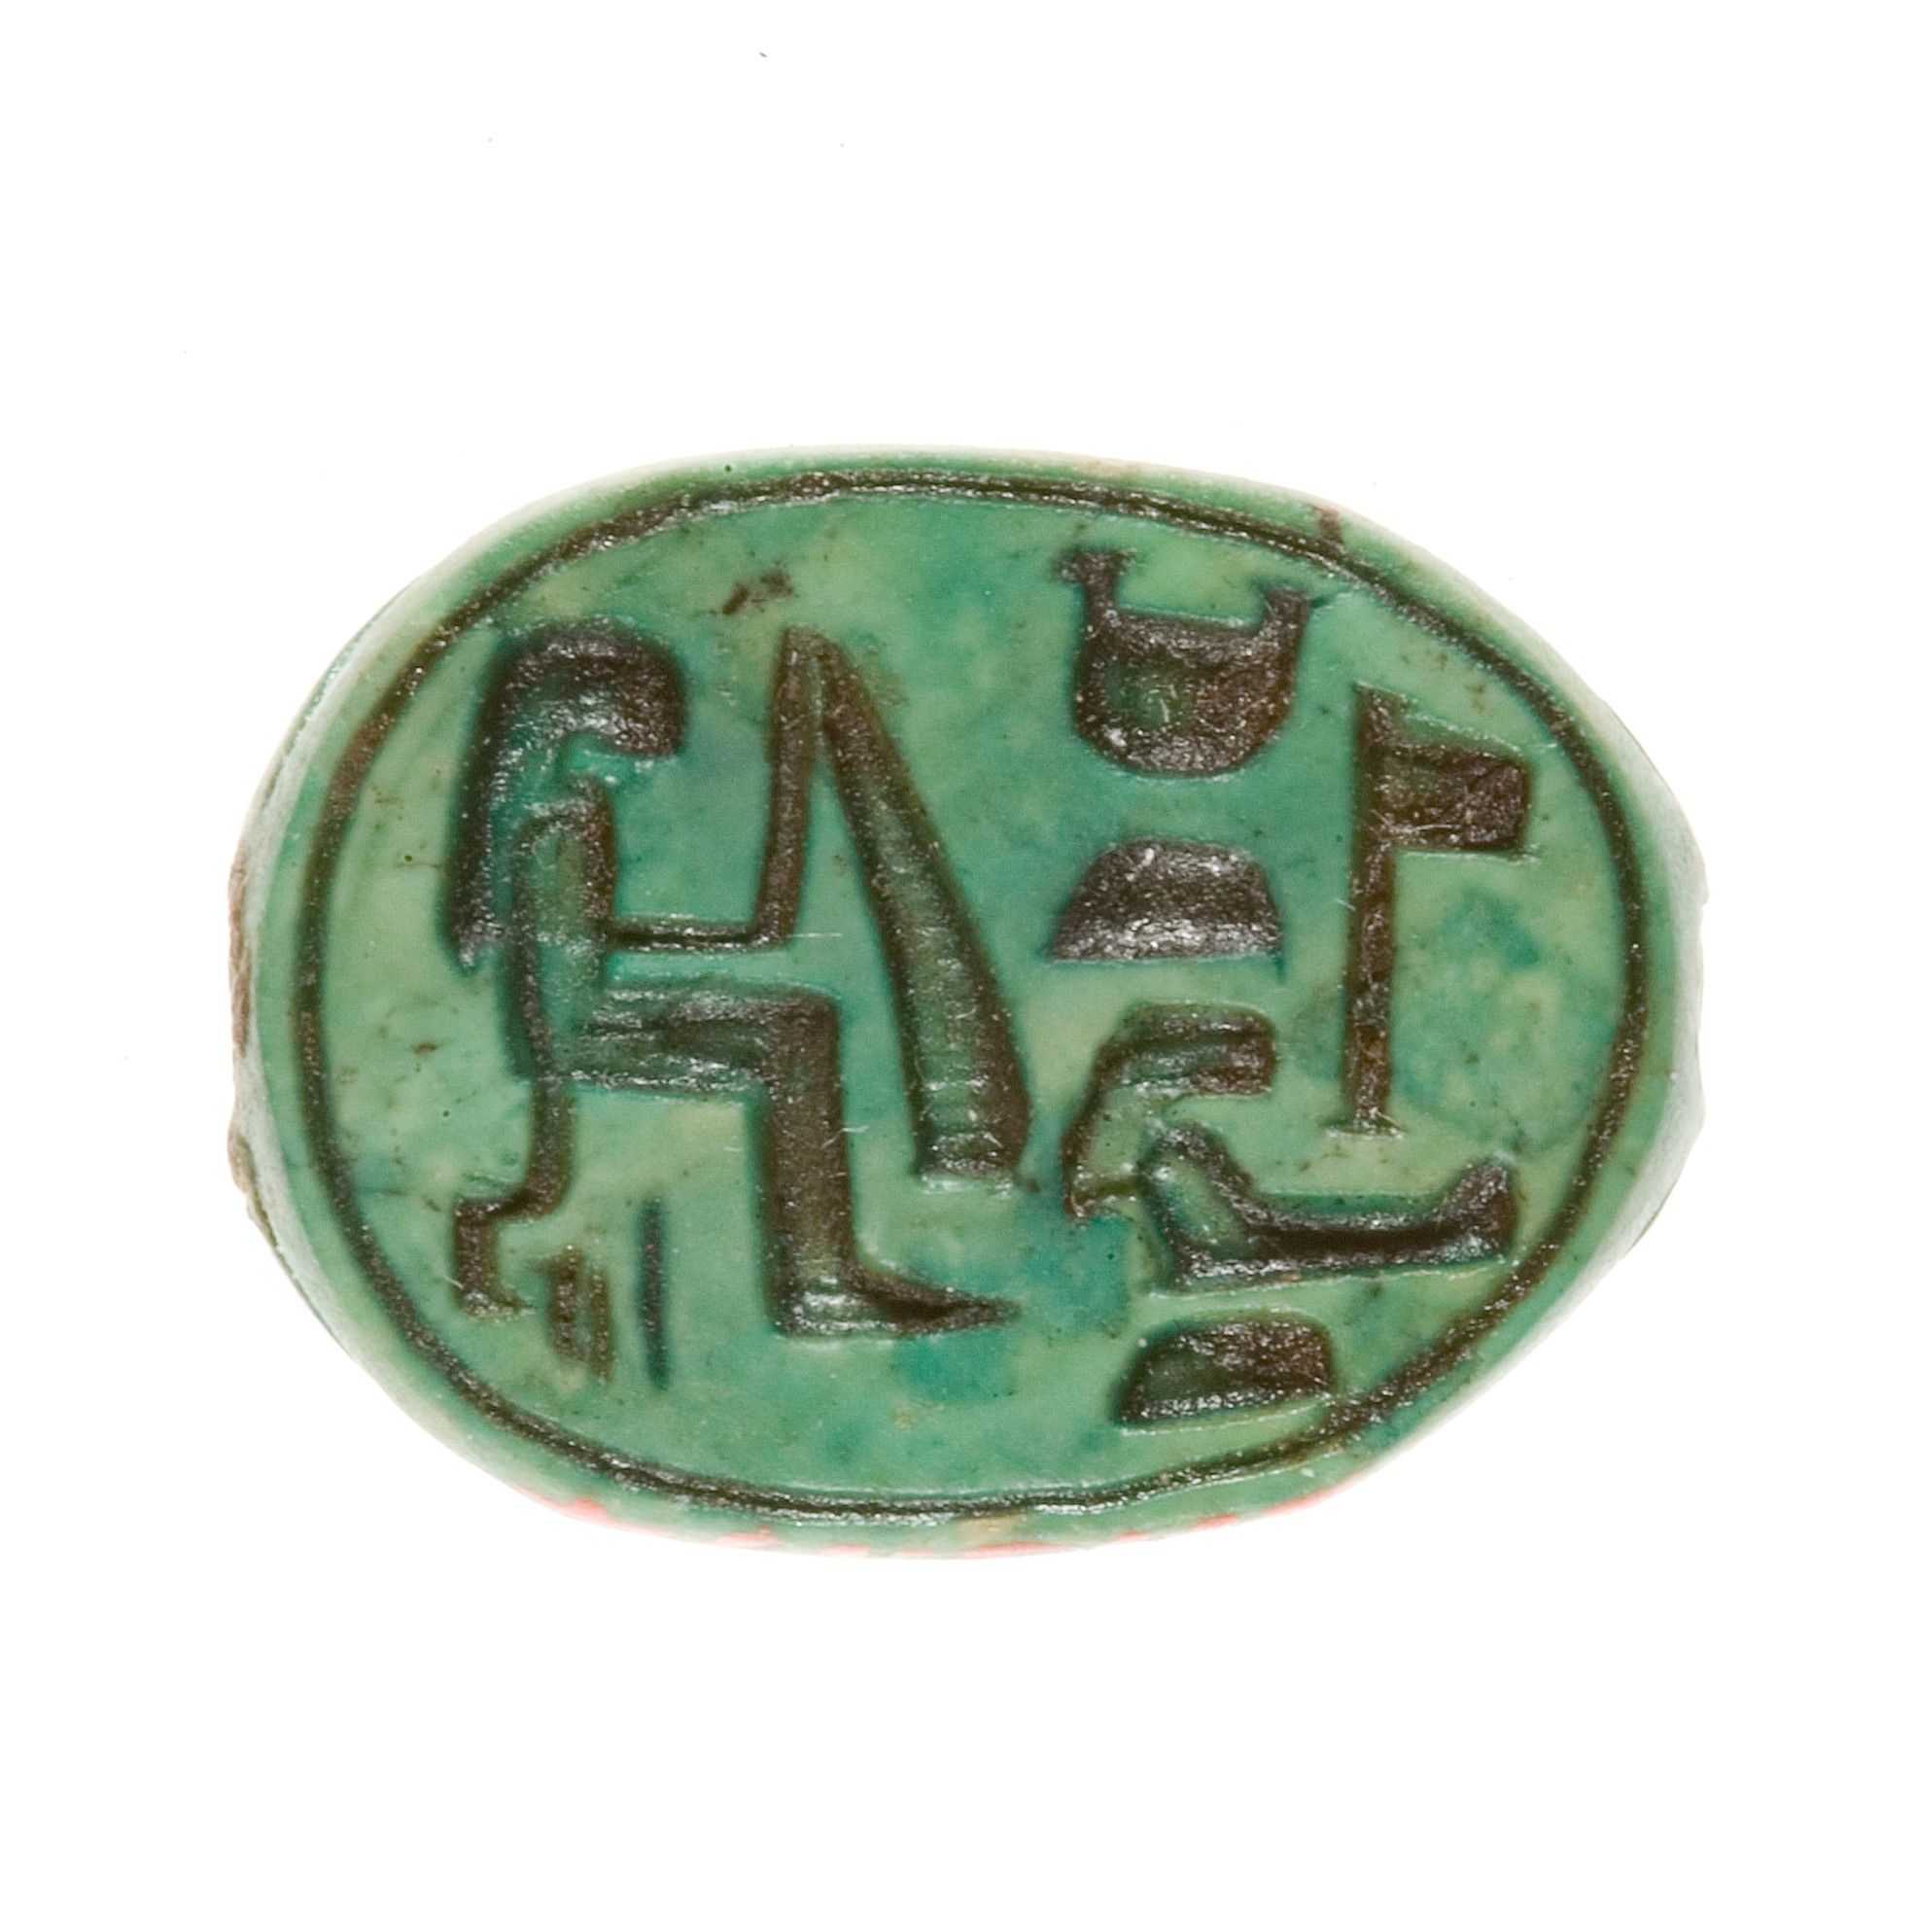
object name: scarab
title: Scarab Inscribed for the God's Wife Hatshepsut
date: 1479-1458 BCE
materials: stone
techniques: glazing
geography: egypt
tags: hieroglyphs,scarabs